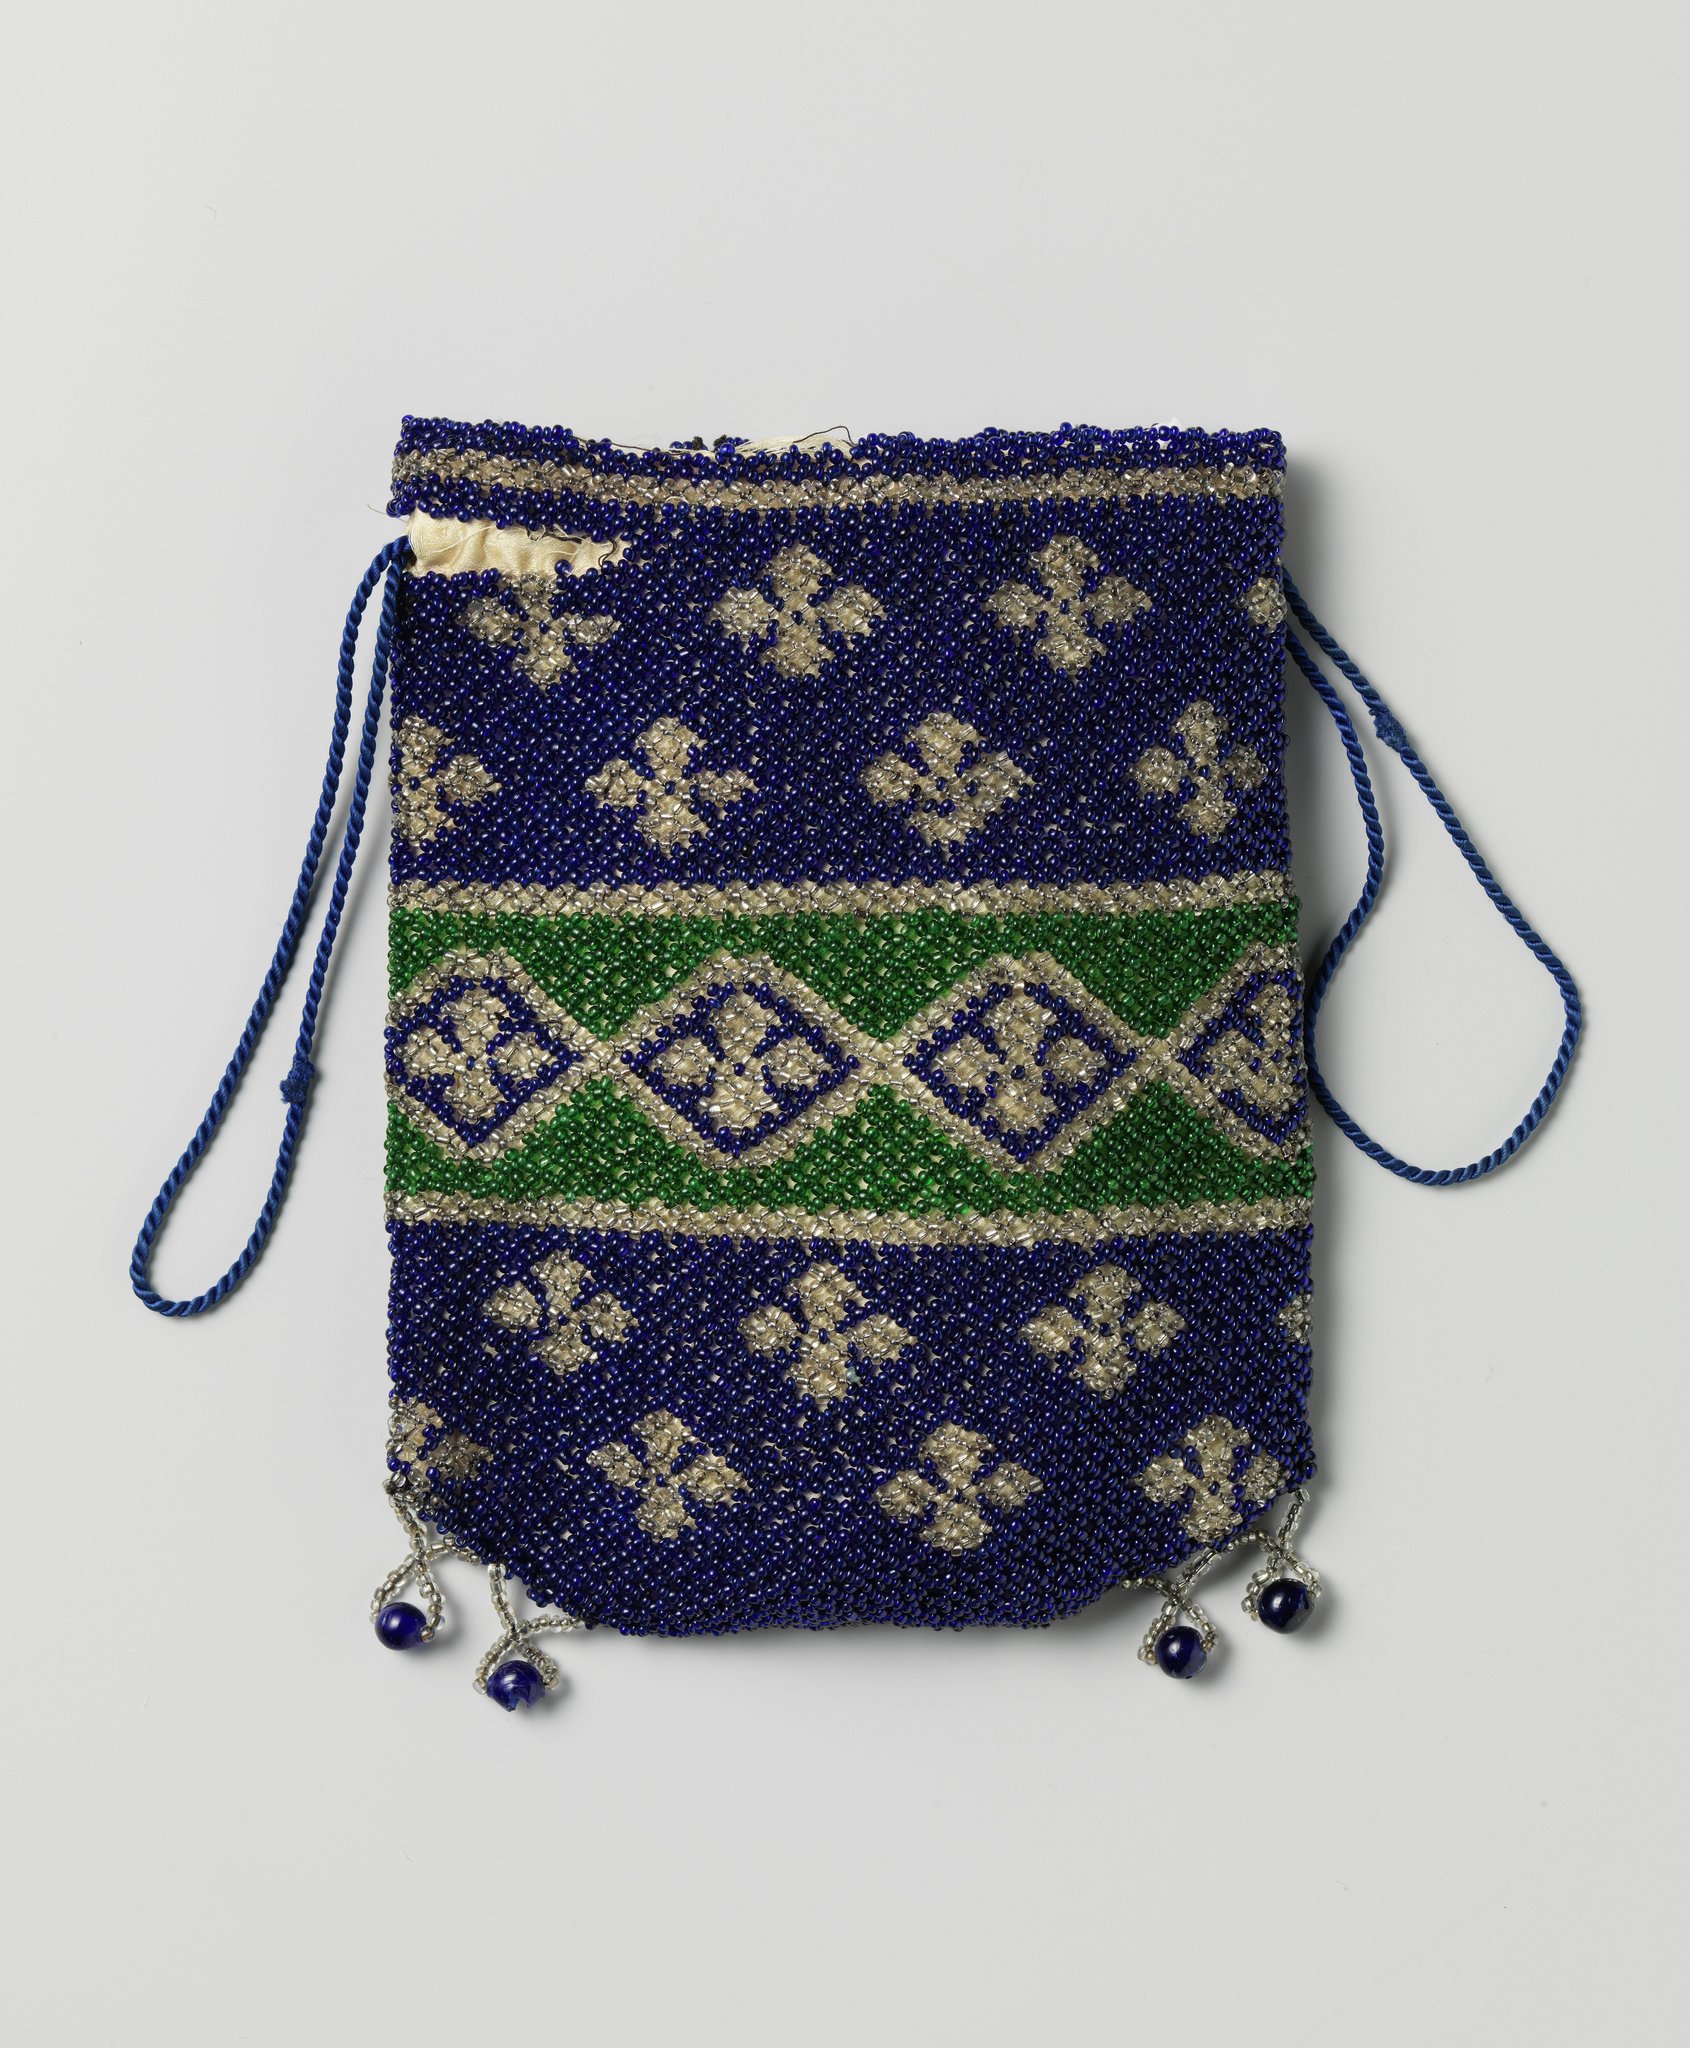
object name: reticule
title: Reticule in een plat rechthoekig model, geheel van blauwe, groene en witte kralen in een geometrisch patroon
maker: Anonymous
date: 1910-1920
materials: glass, silk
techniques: glassblowing, weave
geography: western europe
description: Reticule in blauw, groen en wit. Plat zakmodel met afgeschuinde hoeken en als sluiting twee koorden. Brede blauwe banen met twee rijen witte staan boven- en onderaan en sluiten een smallere groene middenbaan in, waarop een wit schakelmotief staat met blauwe ruiten, wederom met een witte ster gevuld. Twee grote blauwe kralen hangen in de hoeken aan witte kralensnoeren. De kralen staan geweven (?) op diagonale lijnen, beurtelings van volle en halfgevulde toeren, zodat een fijn open raster is ontstaan. Voering van wit satijn.